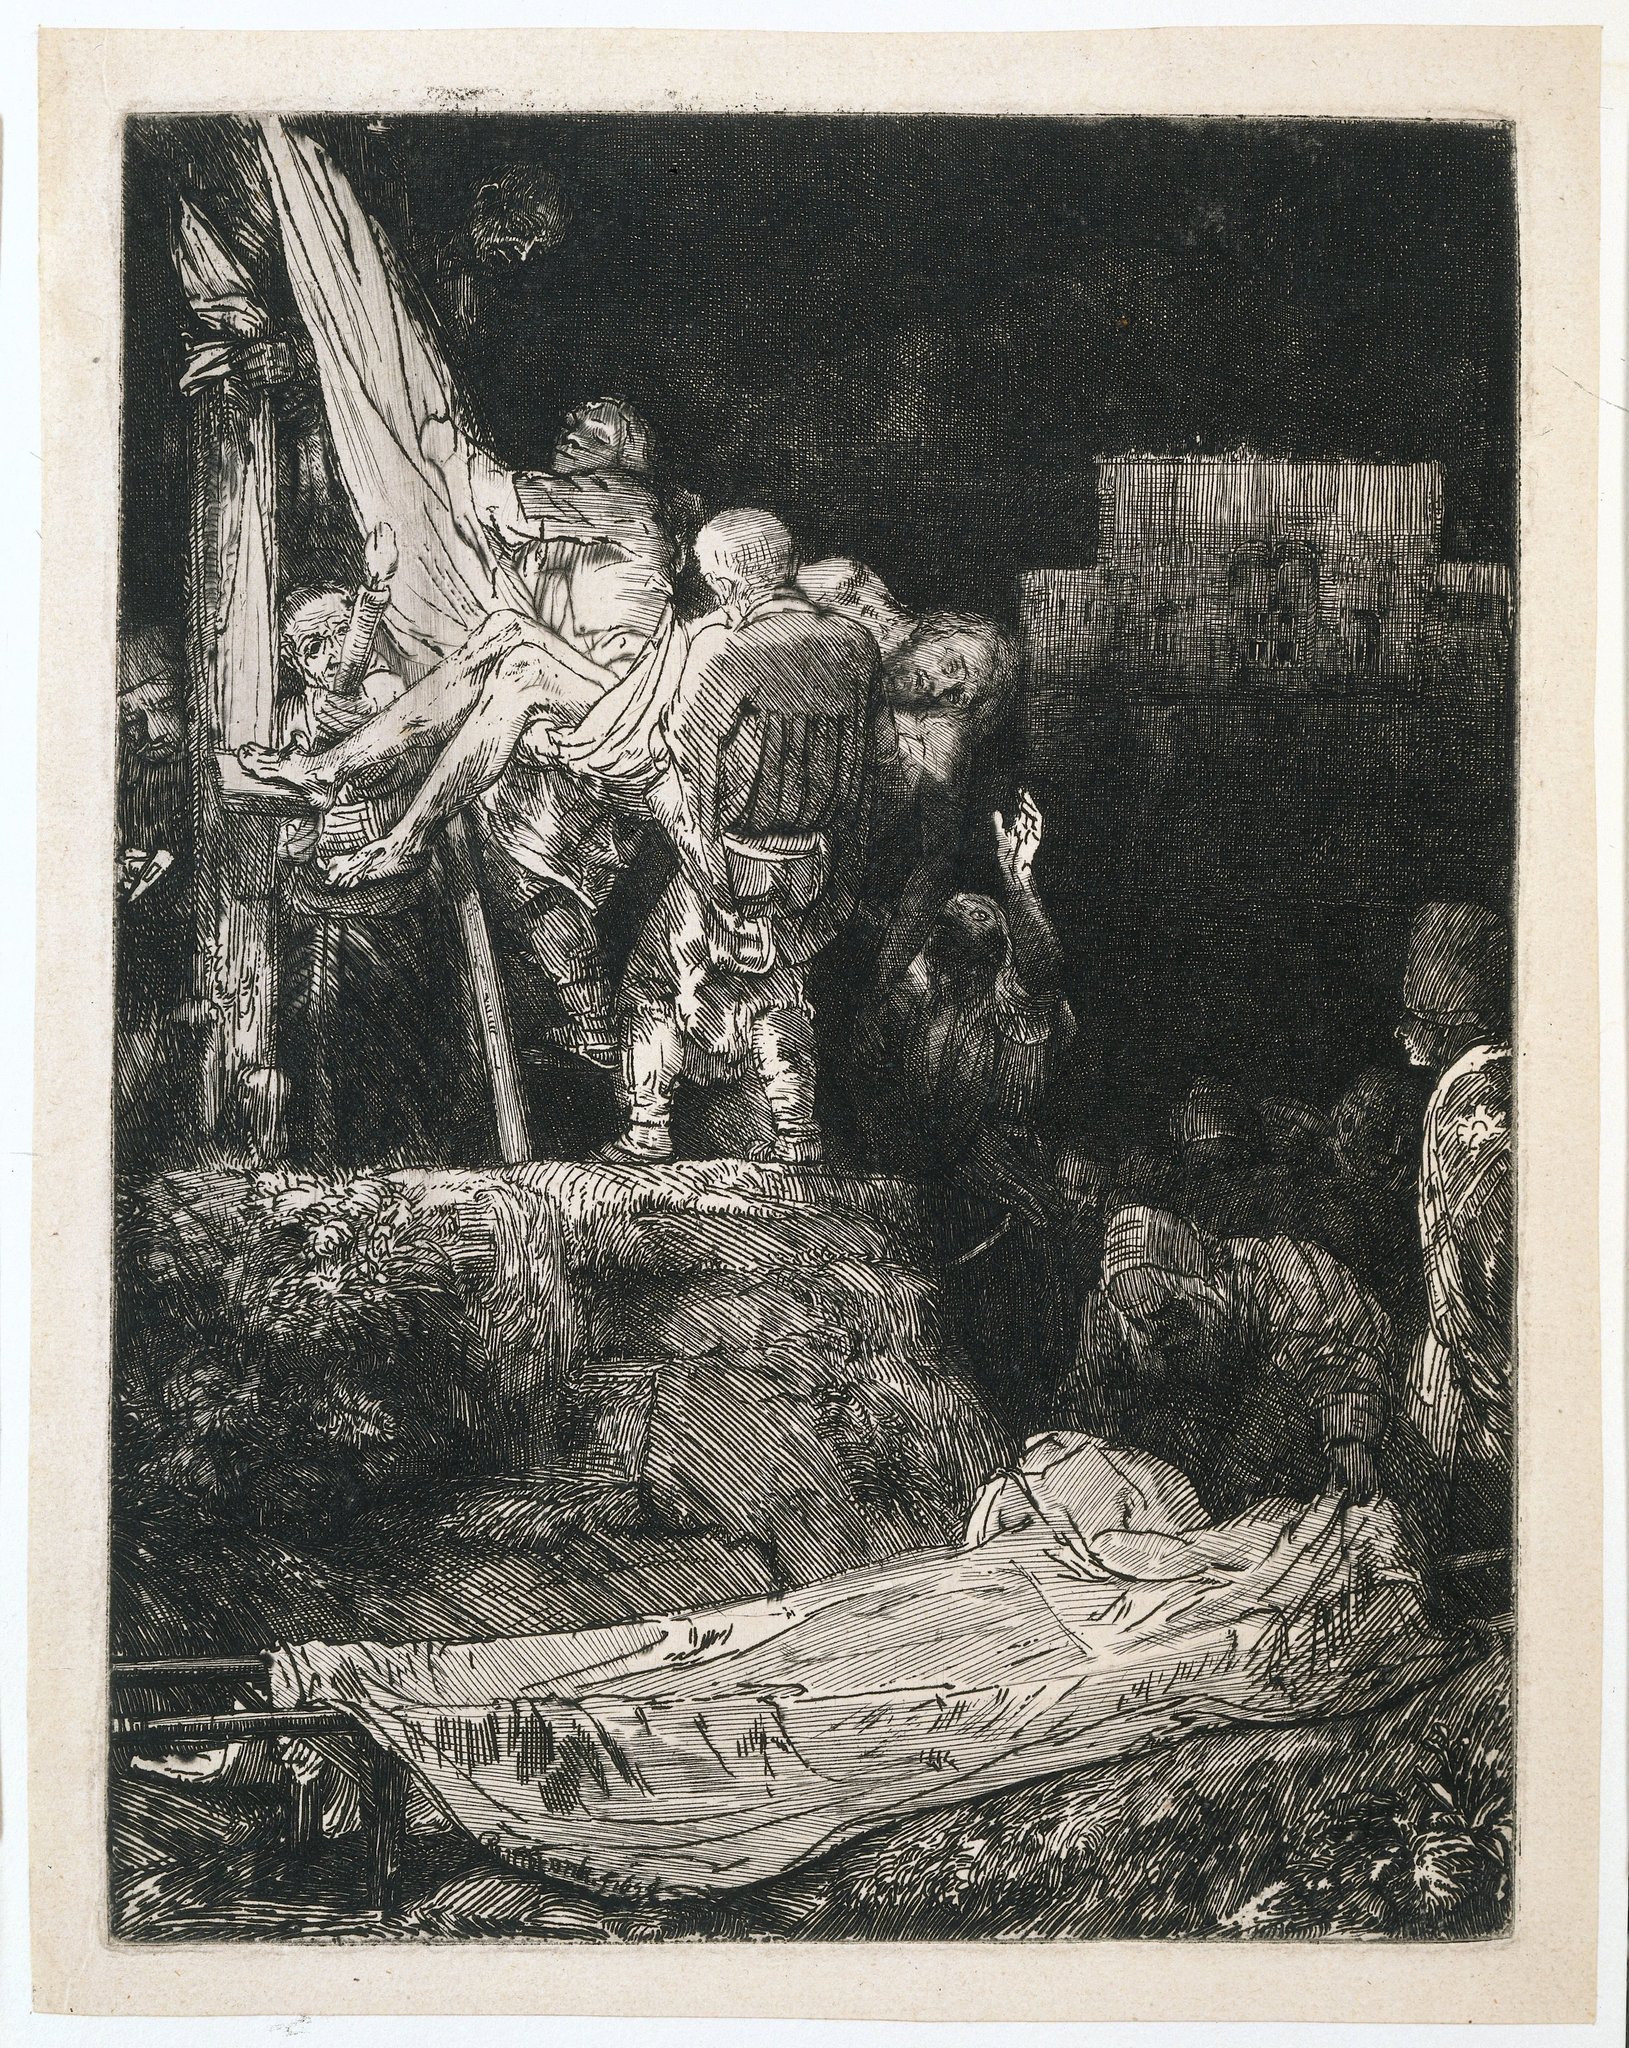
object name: print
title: The descent from the cross by torchlight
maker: rembrandt van rijn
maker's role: draughtsman, painter, print maker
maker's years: 1606-1669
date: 1654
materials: paper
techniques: drypoint, etching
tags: descent from the cross: christ is taken down from the cross, usually by nicodemus and joseph of arimathaea who are standing on the ladders (both arms of christ detached)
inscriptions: signature and date: ‘Rembrandt. f 1654’, mark: Lugt 2228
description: The men taking Christ down from the cross after his death use a linen sheet to carefully lower his body. They are lit by a figure under the ladder holding a torch, the only light source in the scene. Everything directly around the flame is brightly illuminated, while details somewhat further away quickly vanish in the darkness of the night.